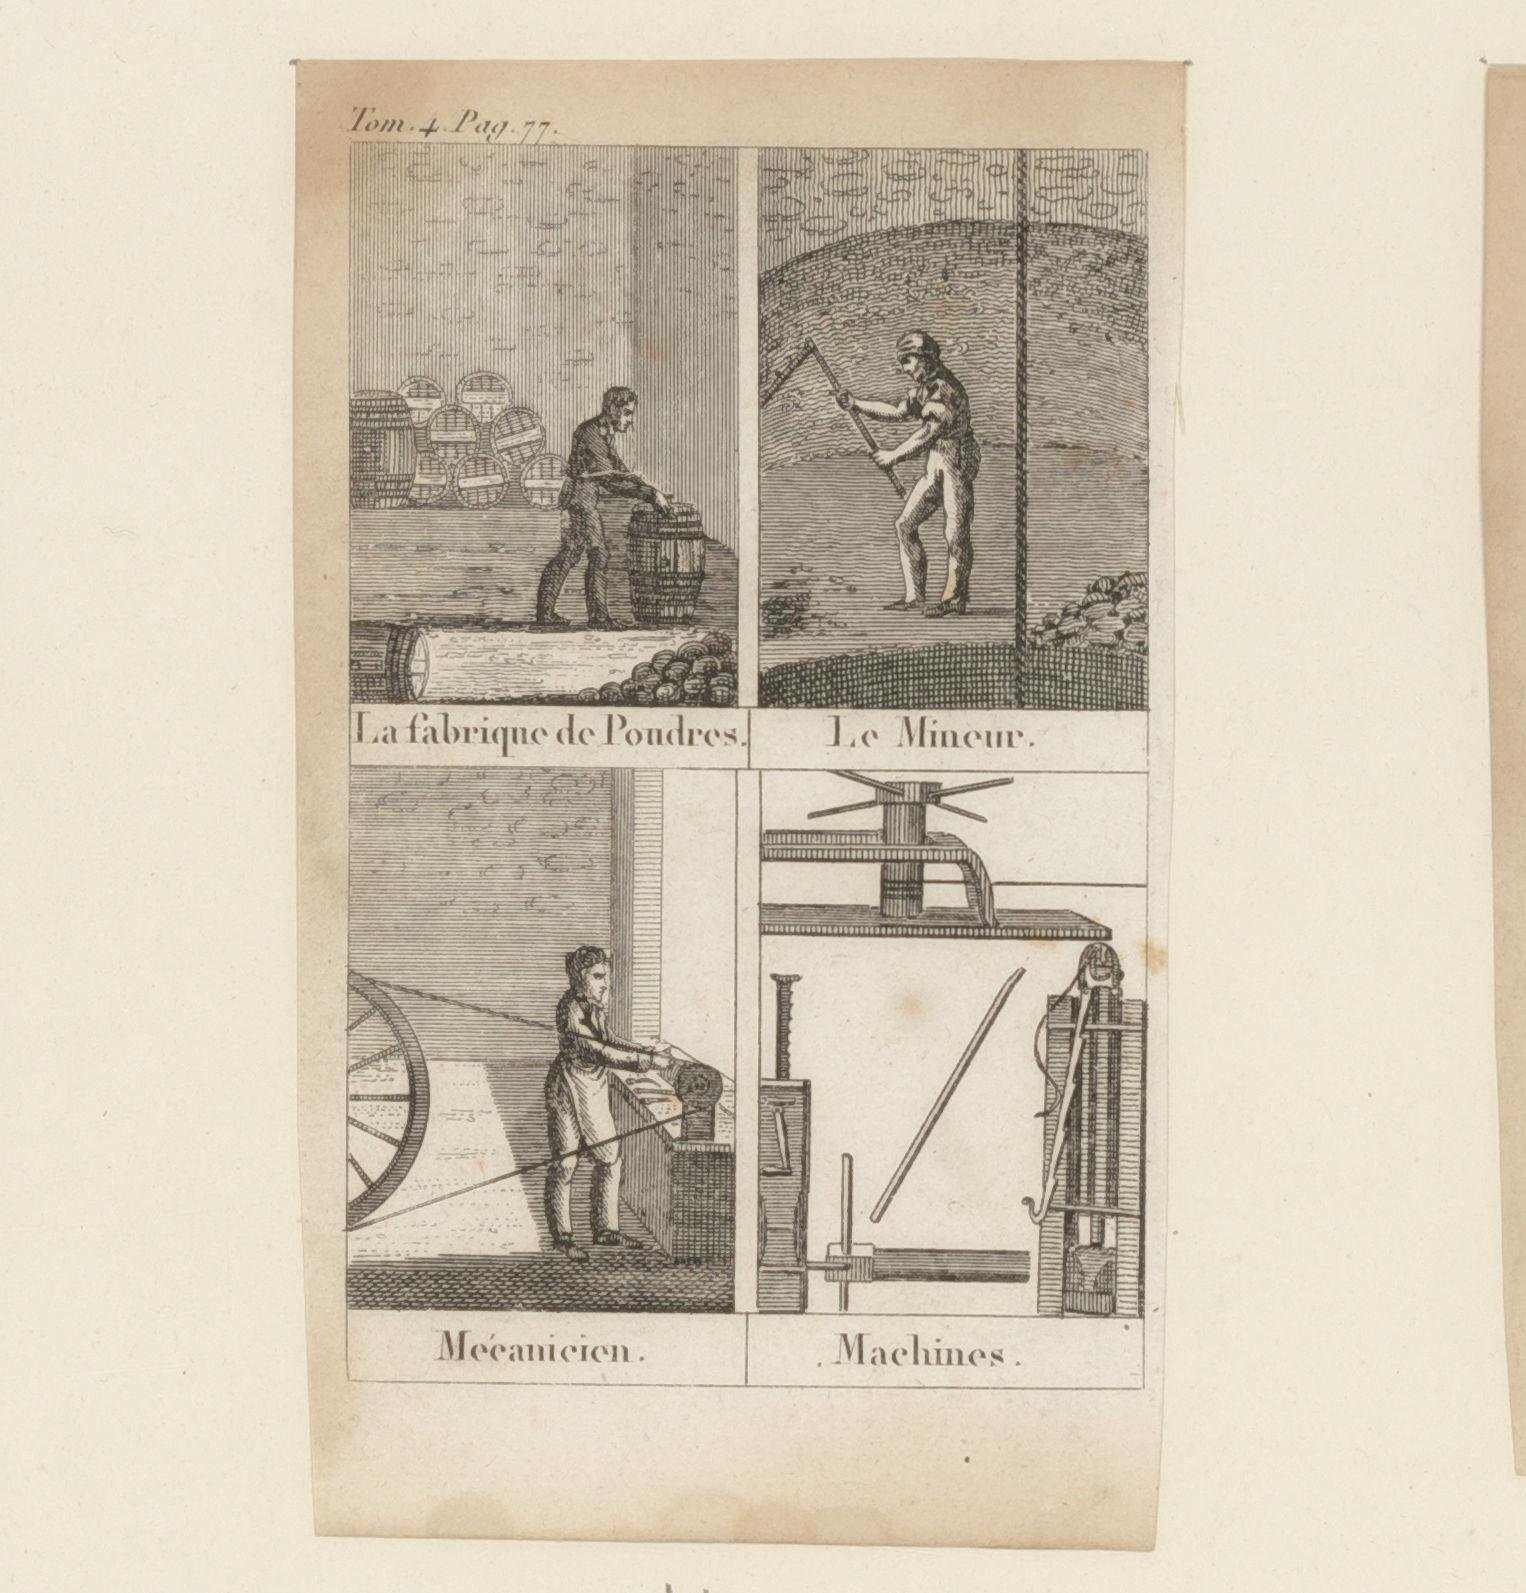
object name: print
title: La fabrique de Pondres, Le Mineur, Mécanicien, Machines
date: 1816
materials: paper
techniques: etching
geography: paris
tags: miner, projectiles, explosives, etc.: gunpowder, parts of machines, mine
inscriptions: collector's mark: Lugt 1641a, collector's mark: Lugt 1641, stamp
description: Vier voorstellingen van beroepen en bedrijven: Kruitfabriek, de mijnwerker, de mechanicus en machines. Bovenaan genummerd: Tom. 4. Pag. 77. Onderwerpsrubrieken binnen de Atlas Zeden en Gewoonten: Handel, Nijverheid en Verkeer, Beroep en Bedrijf, Mannelijk, Complete suites.